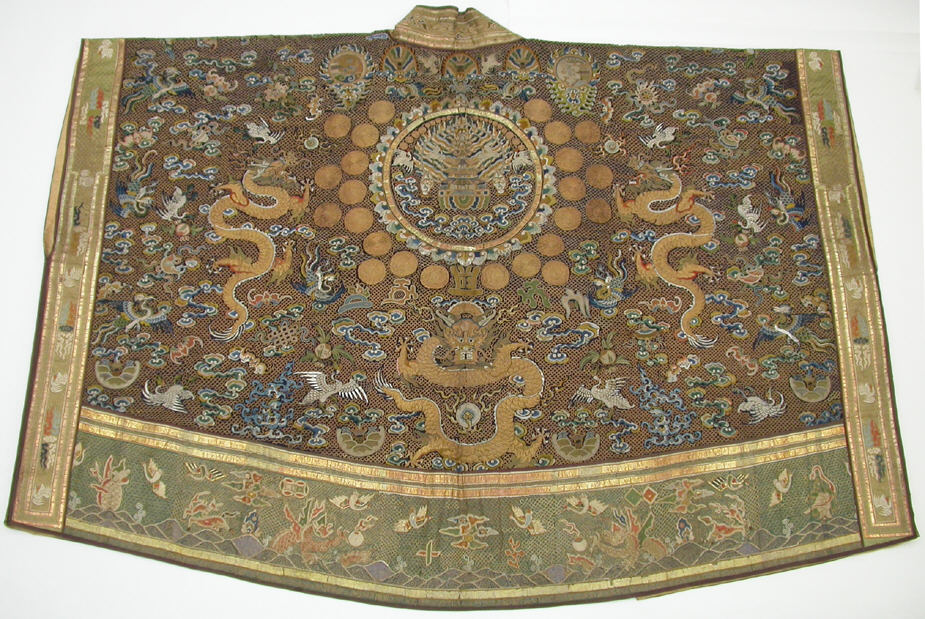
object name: robe, daoist priest's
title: Daoist Priest's Robe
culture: chinese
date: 1701-1800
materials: metal thread, silk